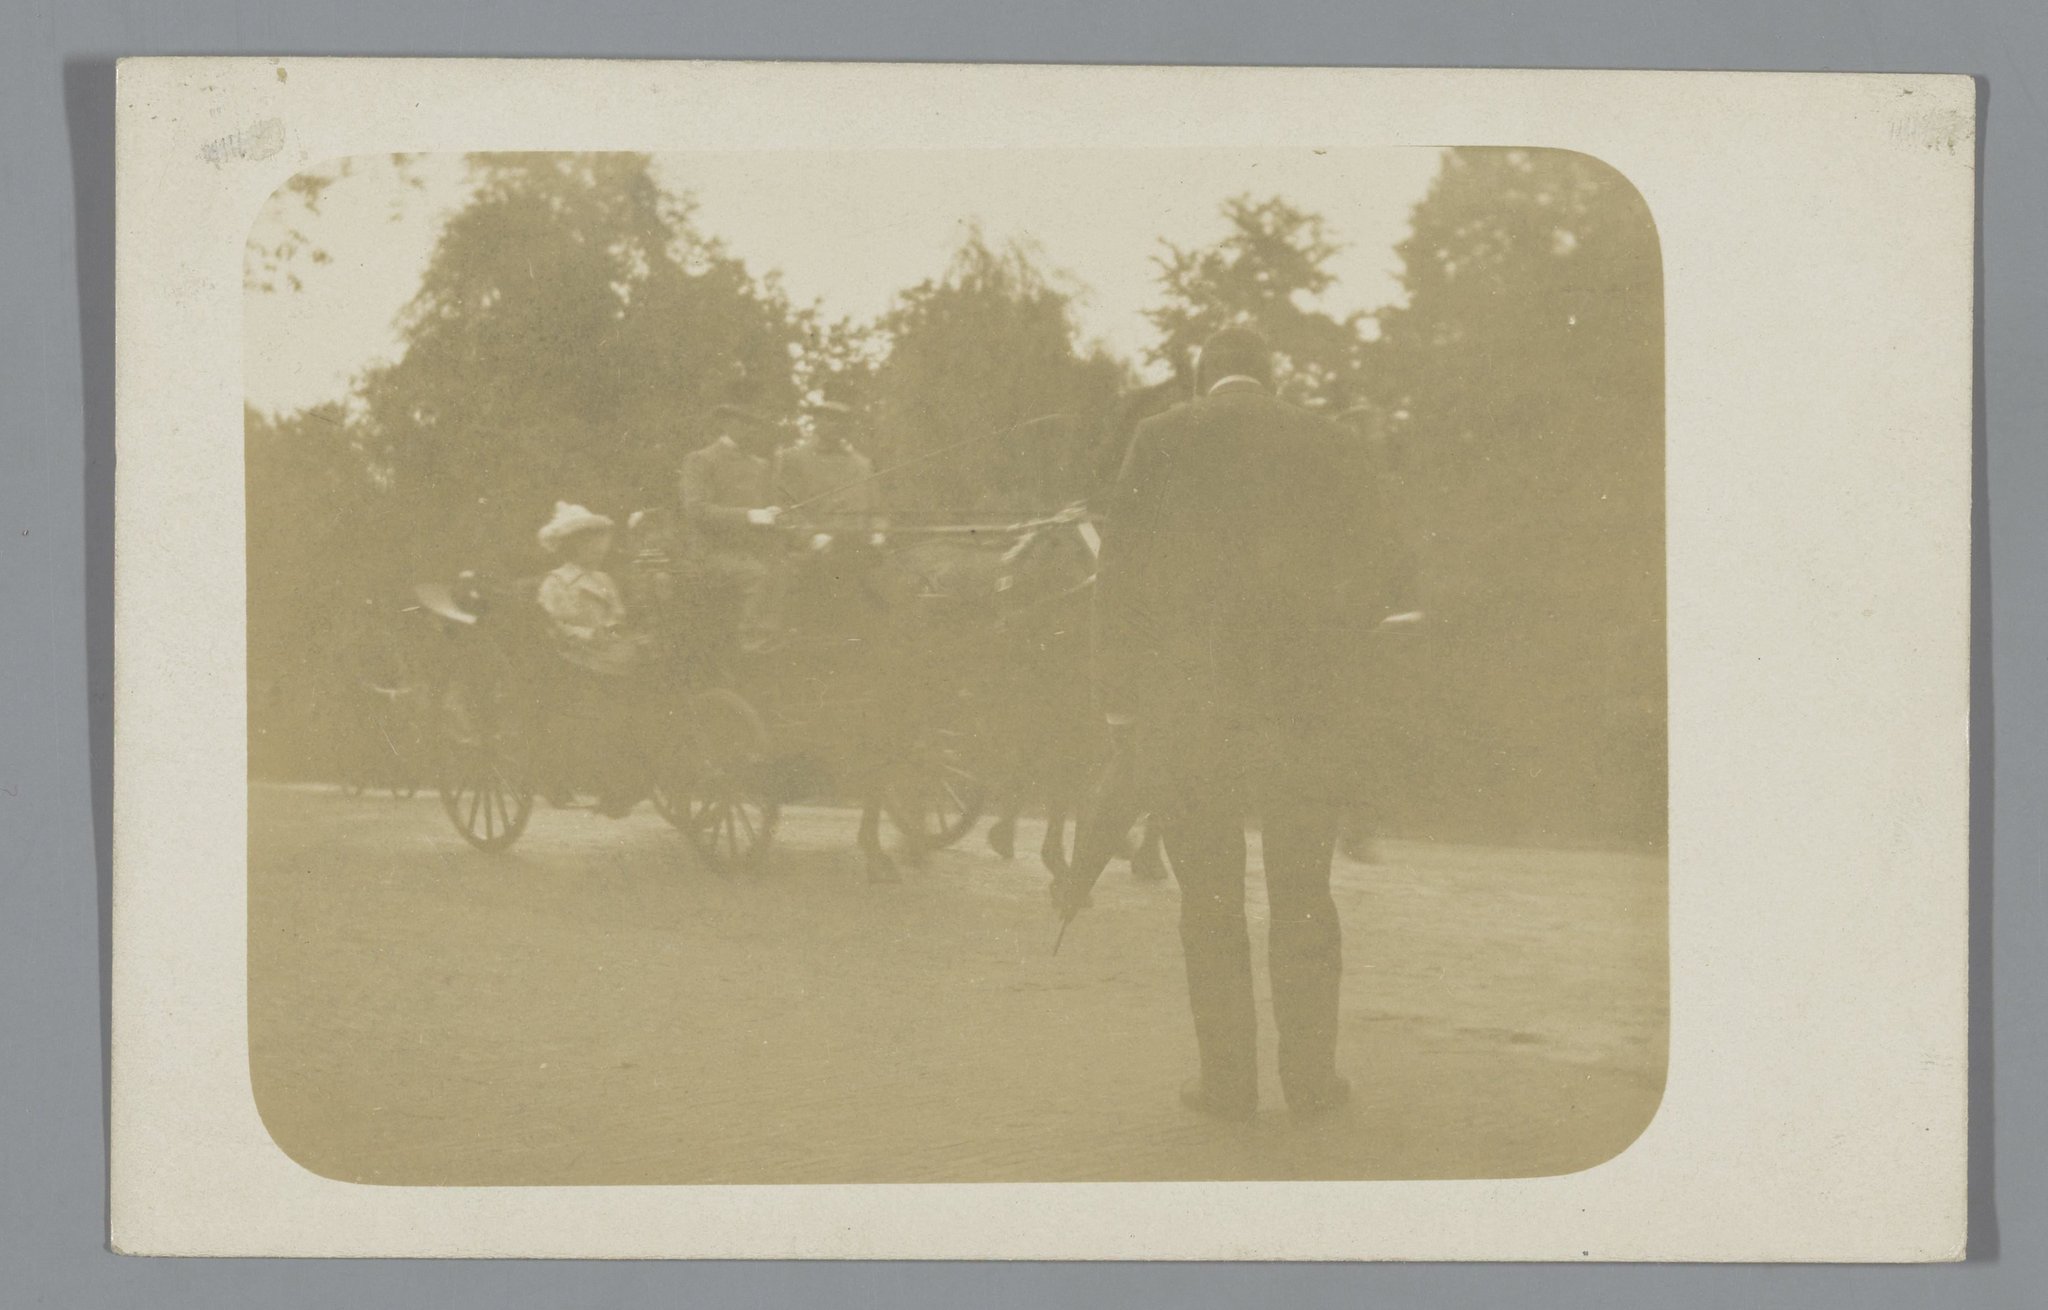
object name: ansichtkaart, prentbriefkaart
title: Koningin Wilhelmina der Nederlanden in een rijtuig op straat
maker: Anonymous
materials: photographic support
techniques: gelatin silver print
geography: netherlands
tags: the hague, wilhelmina of the netherlands, four-wheeled, animal-drawn vehicle, e.g.: cab, carriage, coach, ruler, sovereign - bb - female ruler